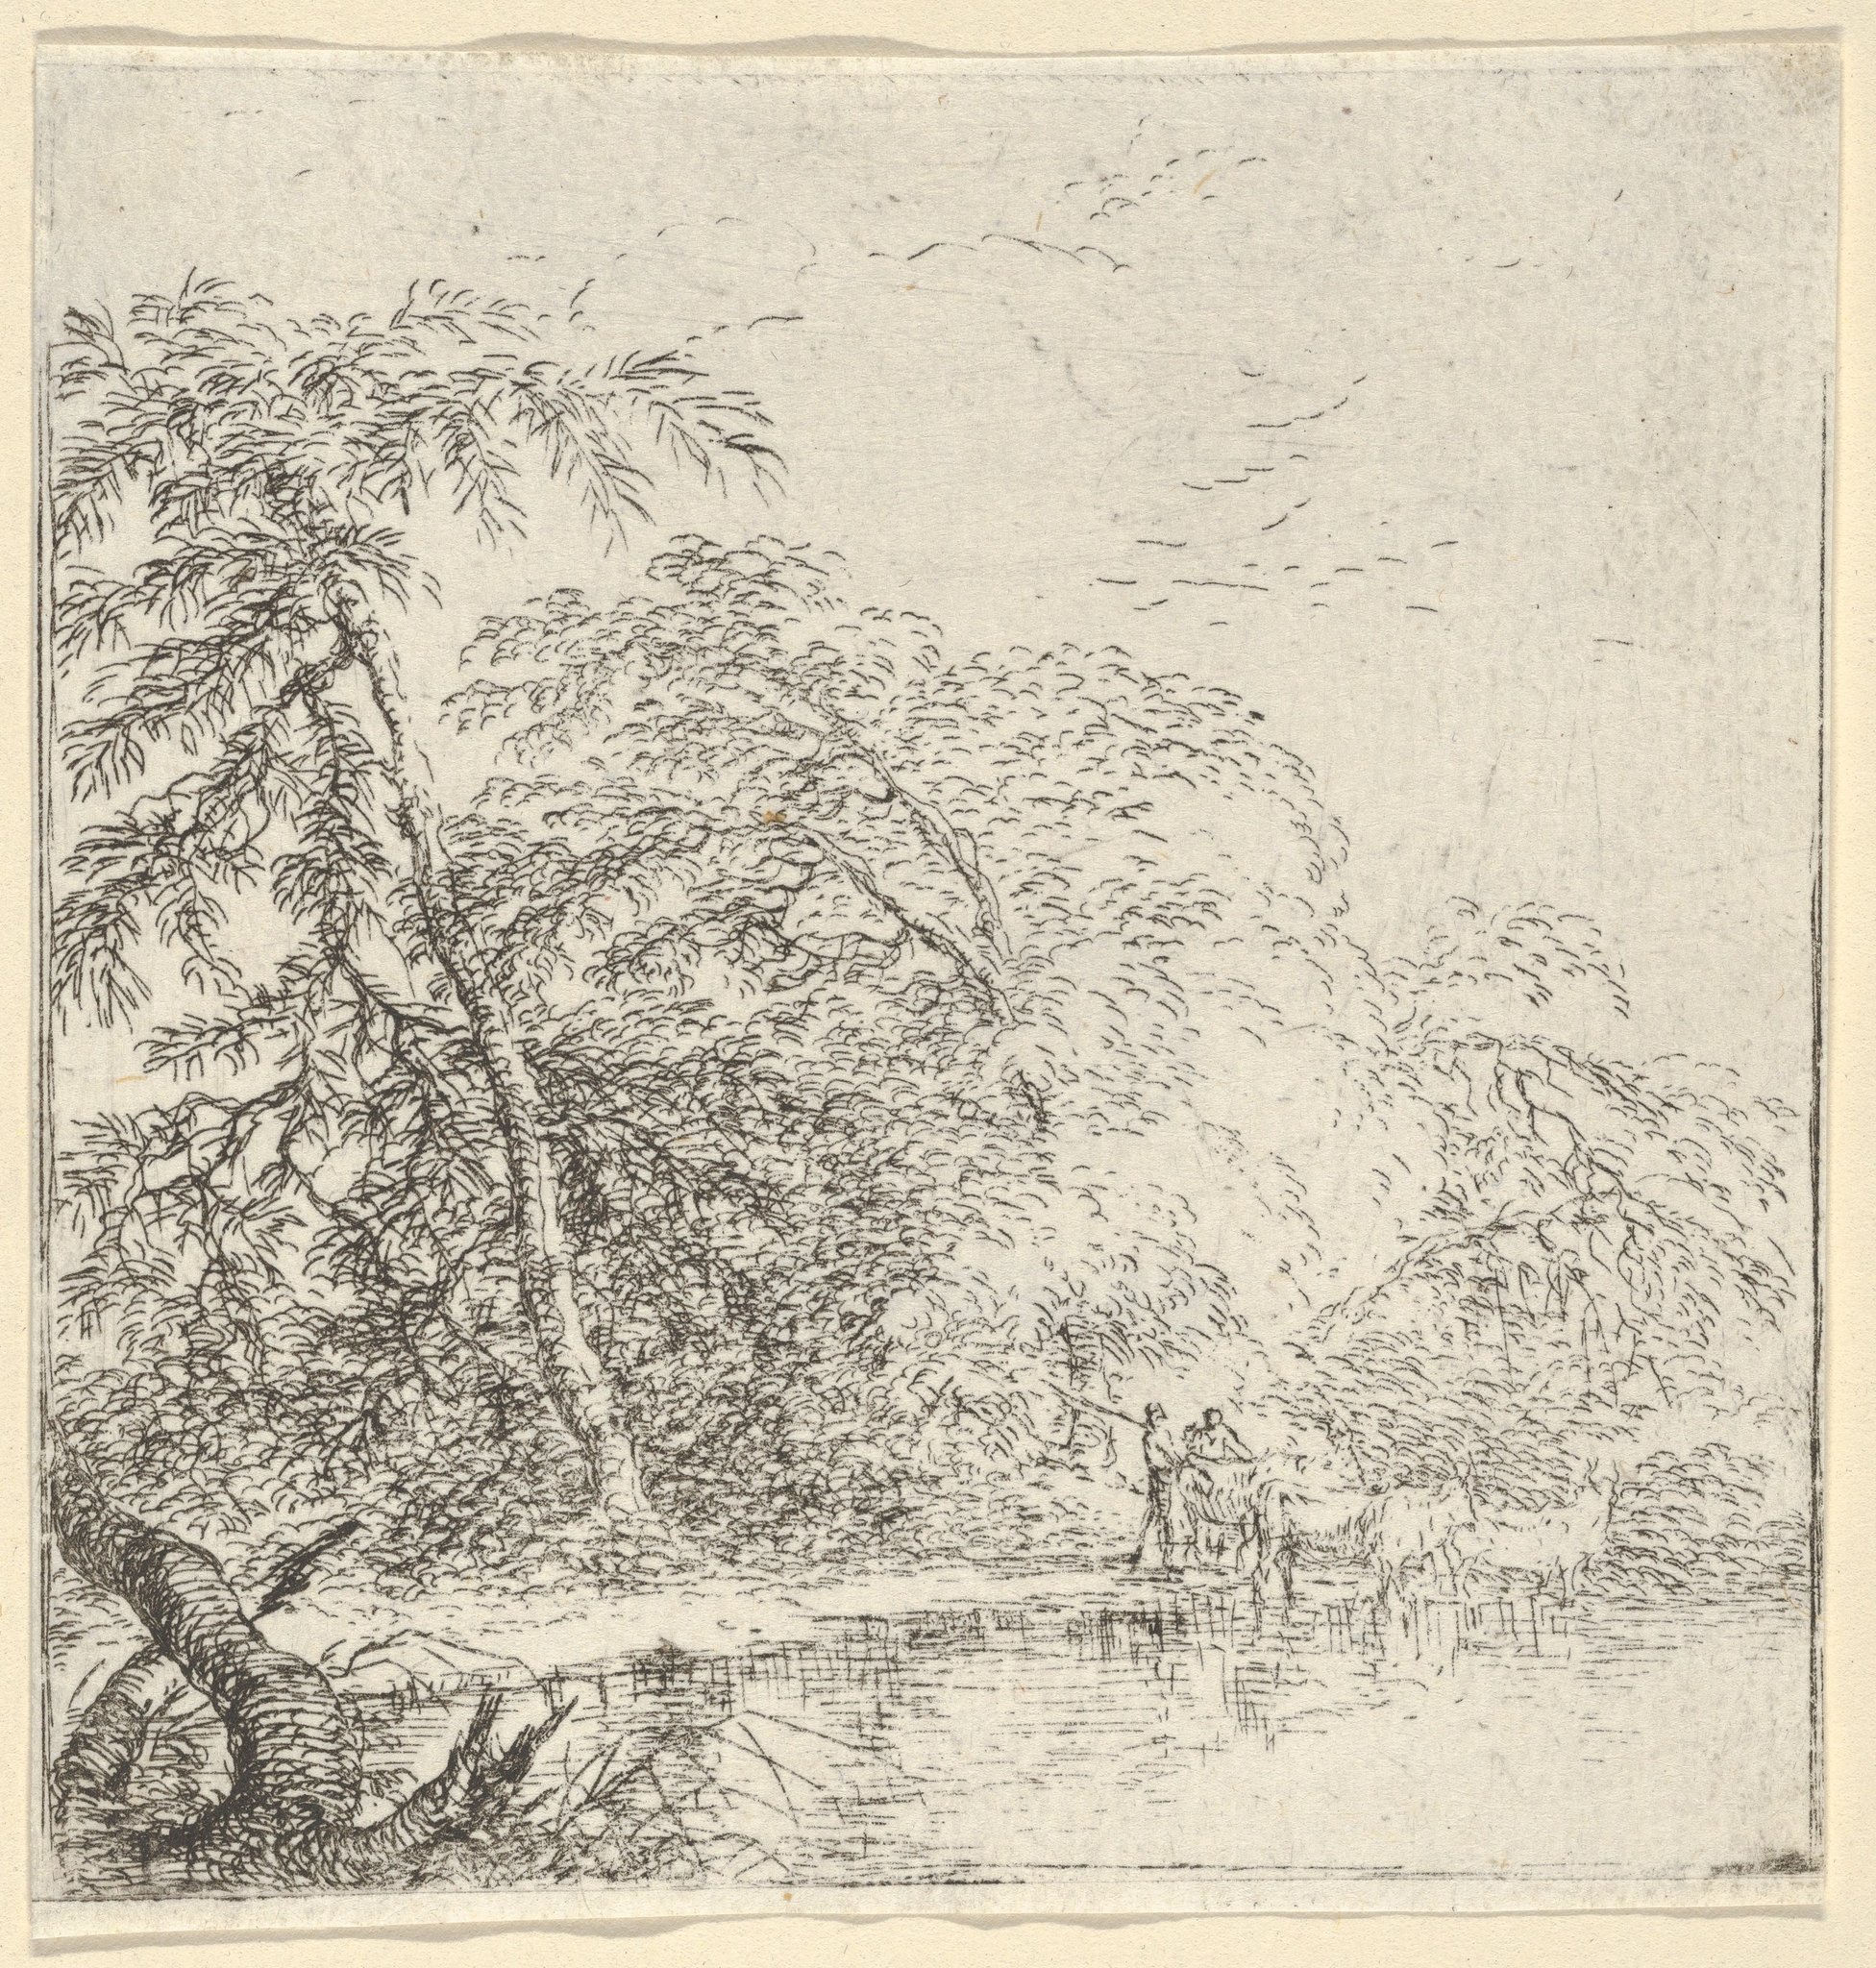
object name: print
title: Landscape with a herdsmen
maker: salvator rosa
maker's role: artist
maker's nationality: italian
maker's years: 1615-1673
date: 1640-1645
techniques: drypoint, etching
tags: human figures,animals,landscapes,trees